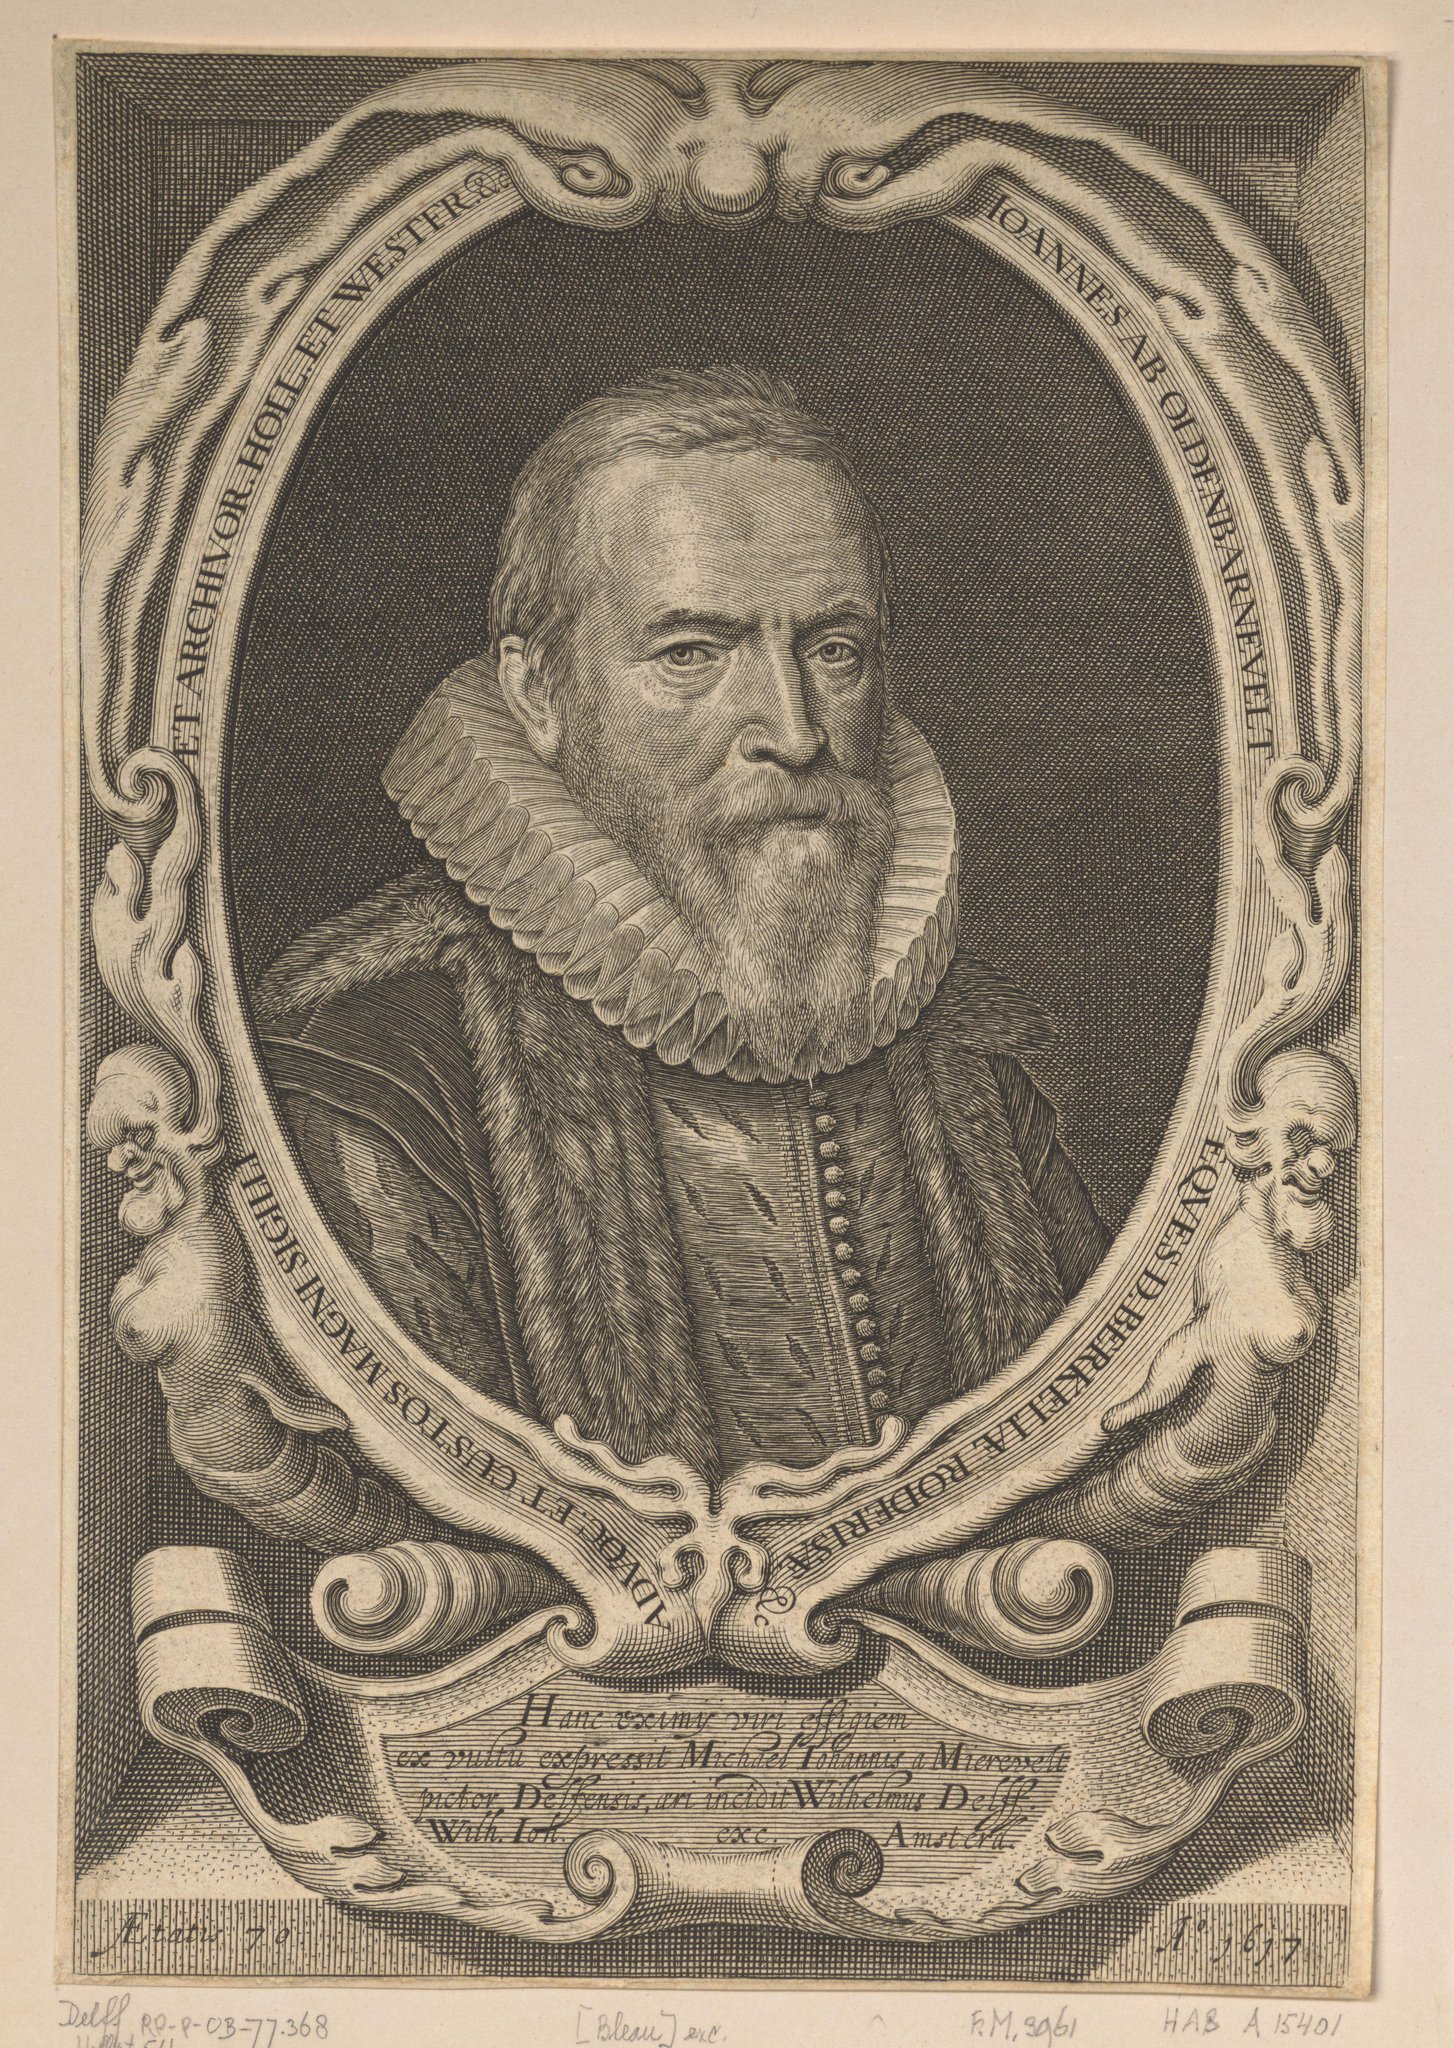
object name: print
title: Portret van Johan van Oldenbarnevelt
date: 1617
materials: paper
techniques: engraving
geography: amsterdam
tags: johan van oldenbarnevelt, historical persons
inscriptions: date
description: Portret van Johan van Oldenbarnevelt op zeventigjarige leeftijd, in ovale ornamentale omlijsting. Onder het portret de namen van de geportretteerde en de vervaardigers in het Latijn. De prent is gegraveerd naar het schilderij van Michiel van Miereveld.